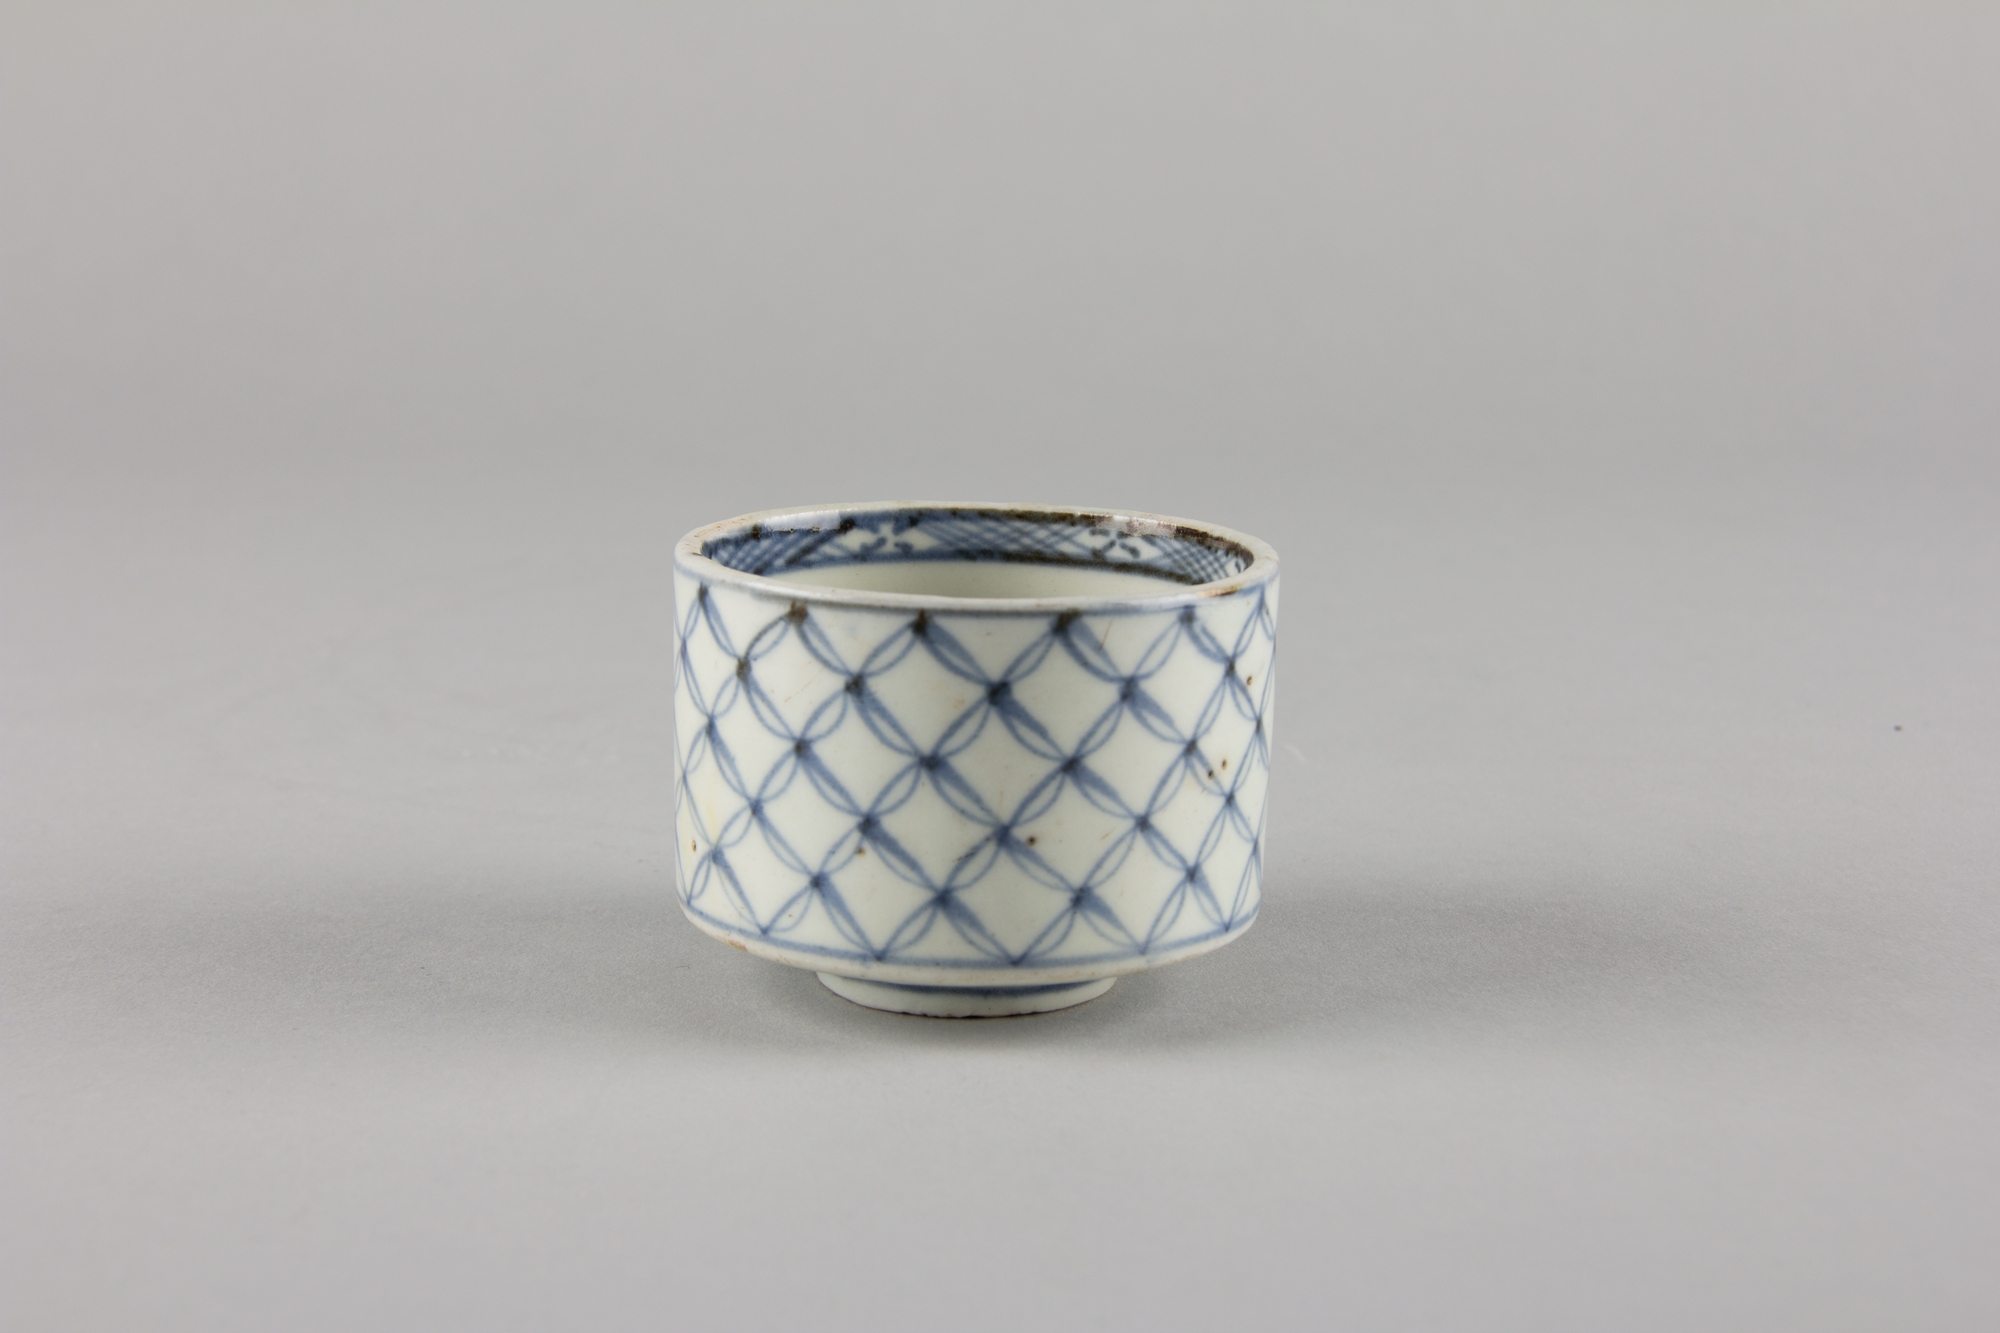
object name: soba cup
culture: japanese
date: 1700-1750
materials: porcelain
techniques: underglaze